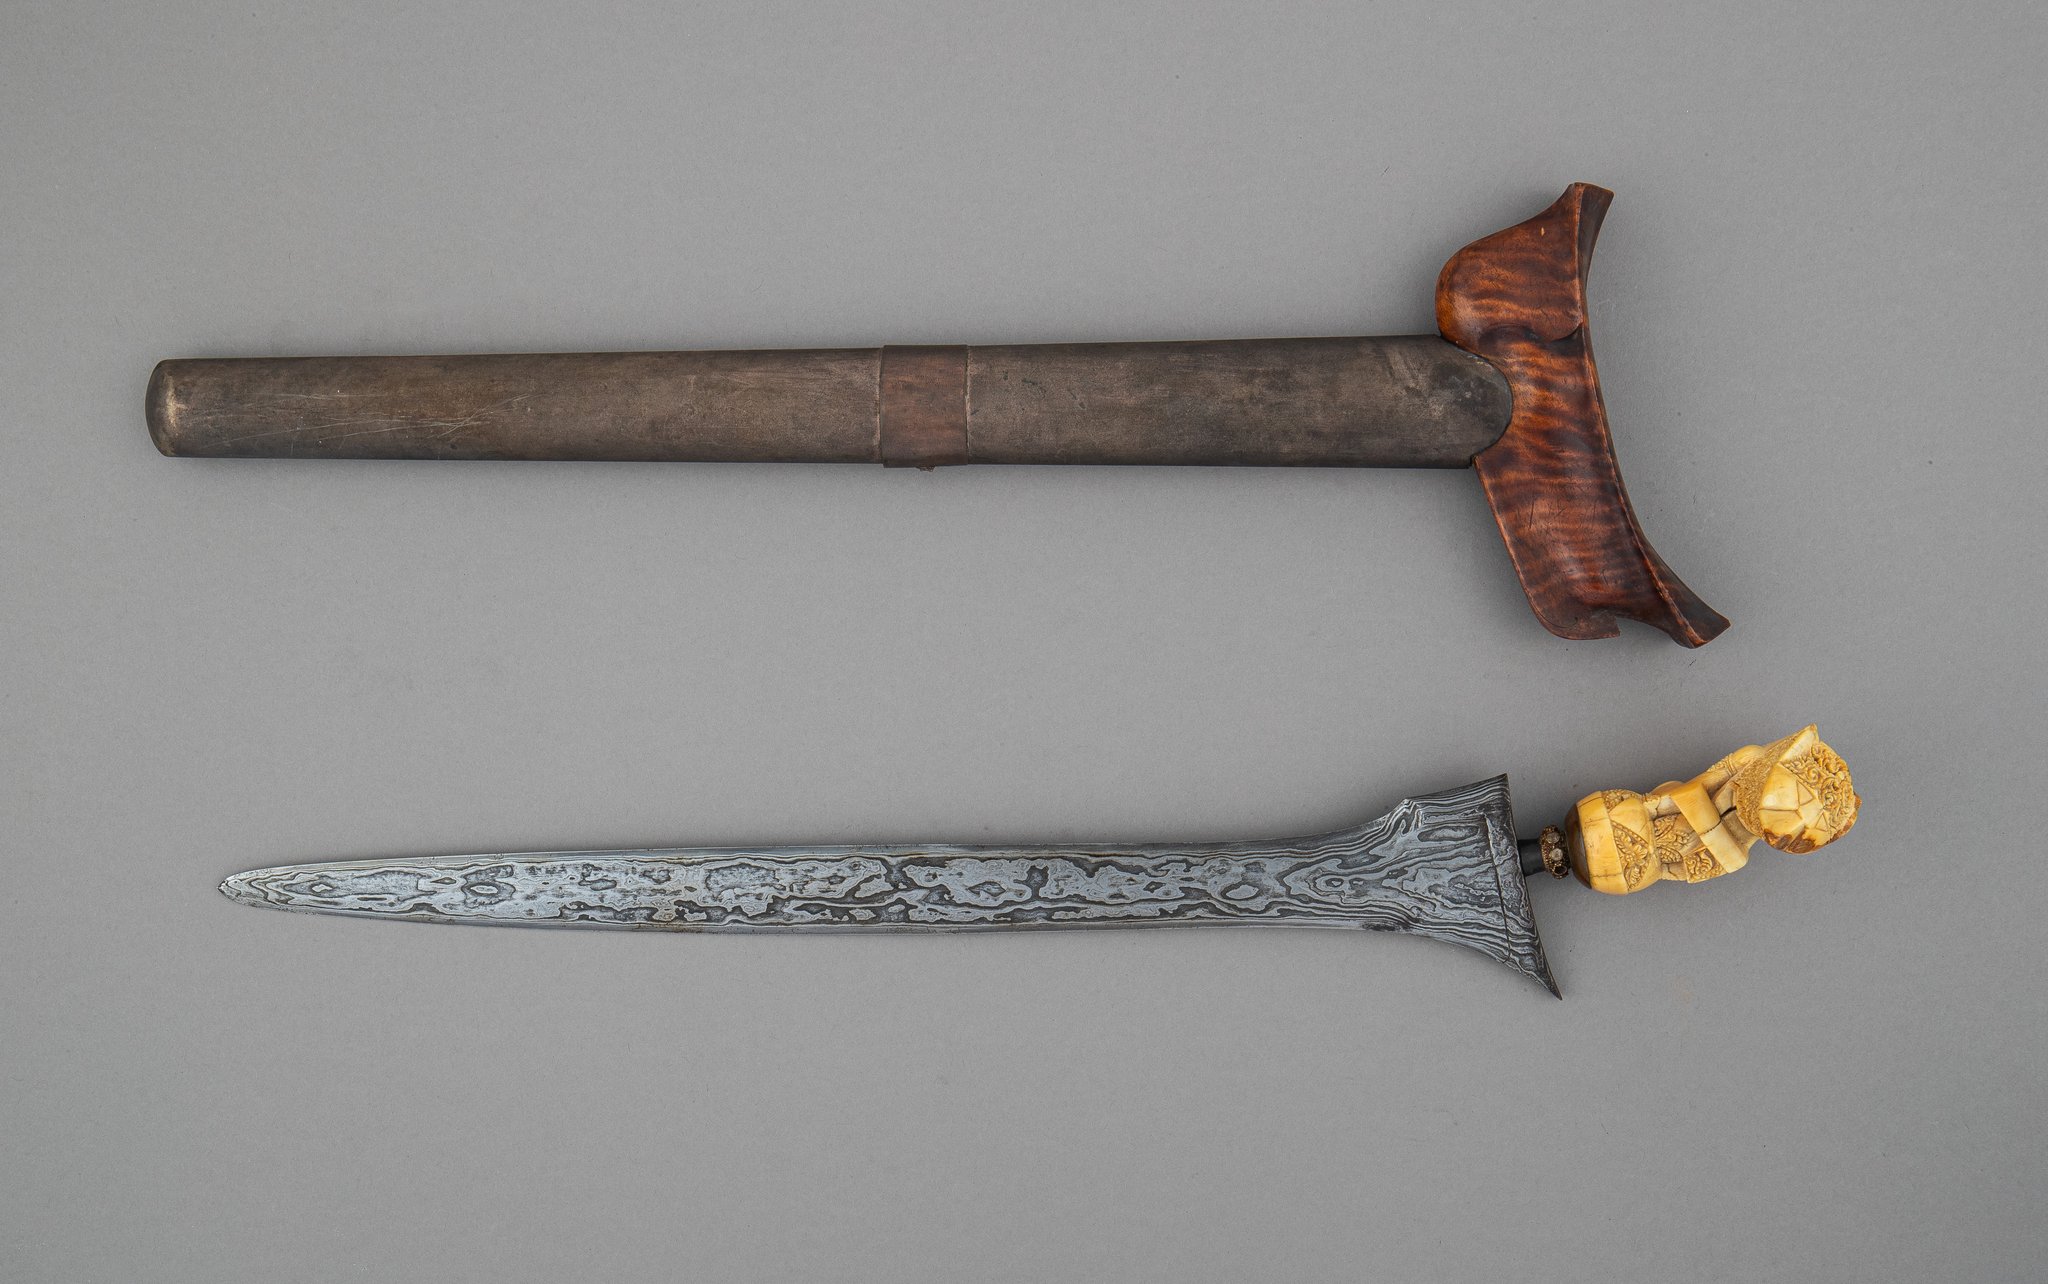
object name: kris with sheath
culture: sumatran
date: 1501-1900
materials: copper, ivory, silver, steel, stone, wood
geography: indonesia